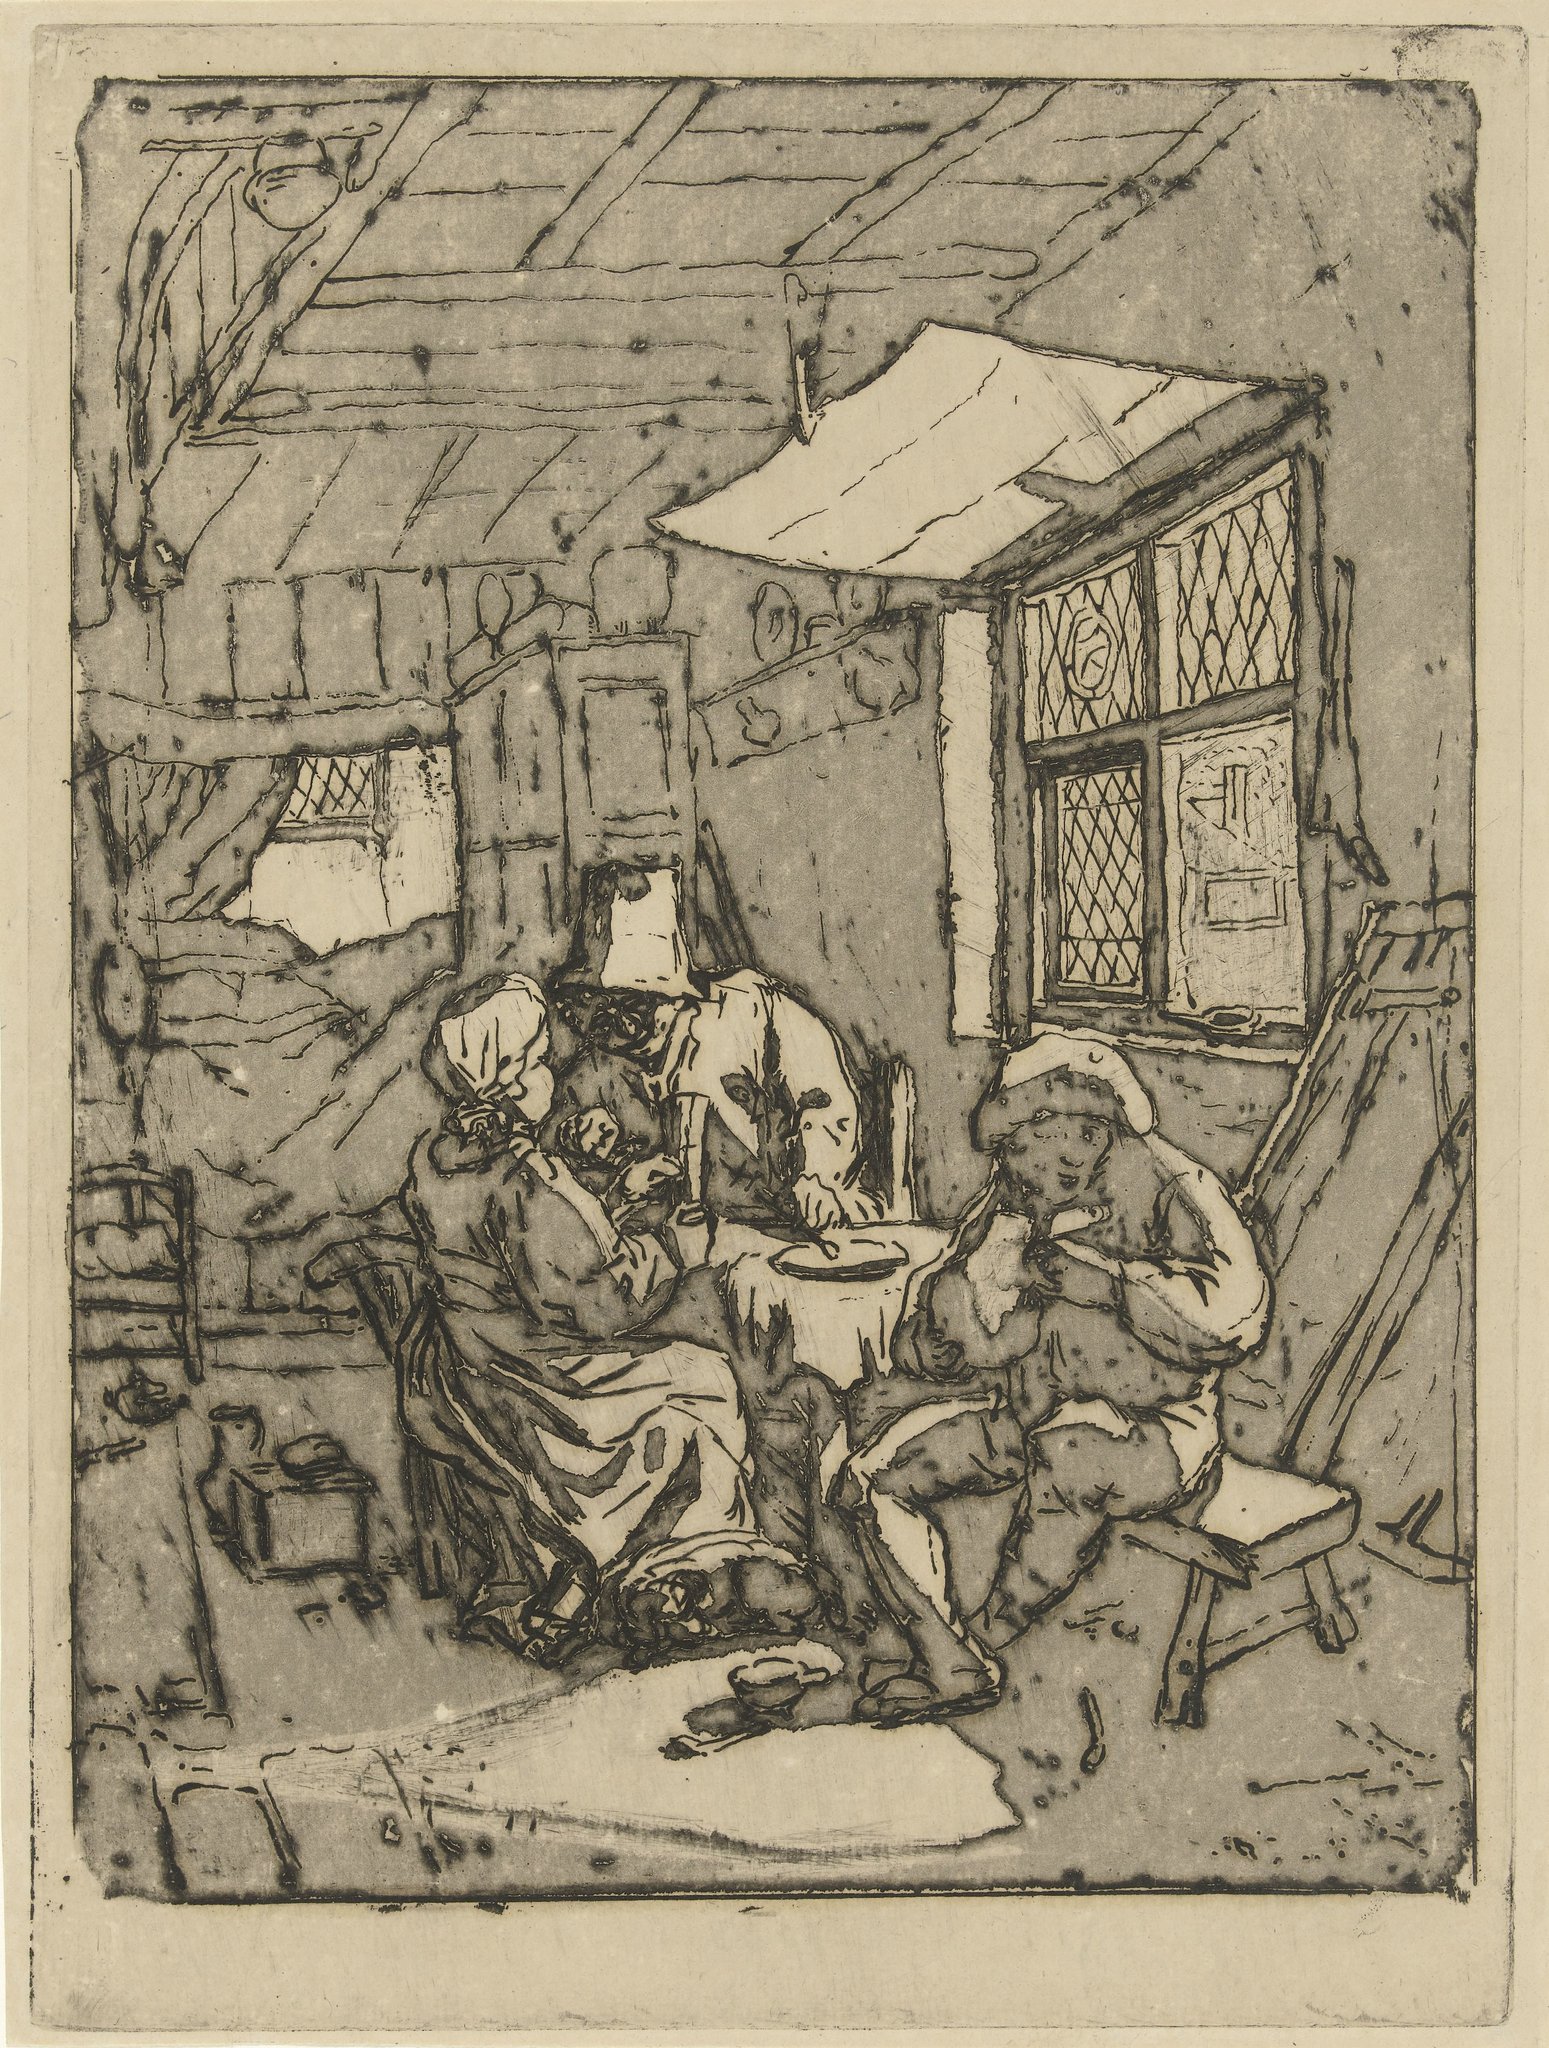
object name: print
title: Boereninterieur (tweede versie)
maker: jabes heenck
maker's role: draughtsman, print maker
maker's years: 1752-1782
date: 1767-1782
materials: paper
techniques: aquatint, drypoint, etching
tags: interior of the house, open window, drinking, dog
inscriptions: collector's mark: Lugt 240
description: Drie figuren aan een tafel bij een open raam in een boereninterieur.